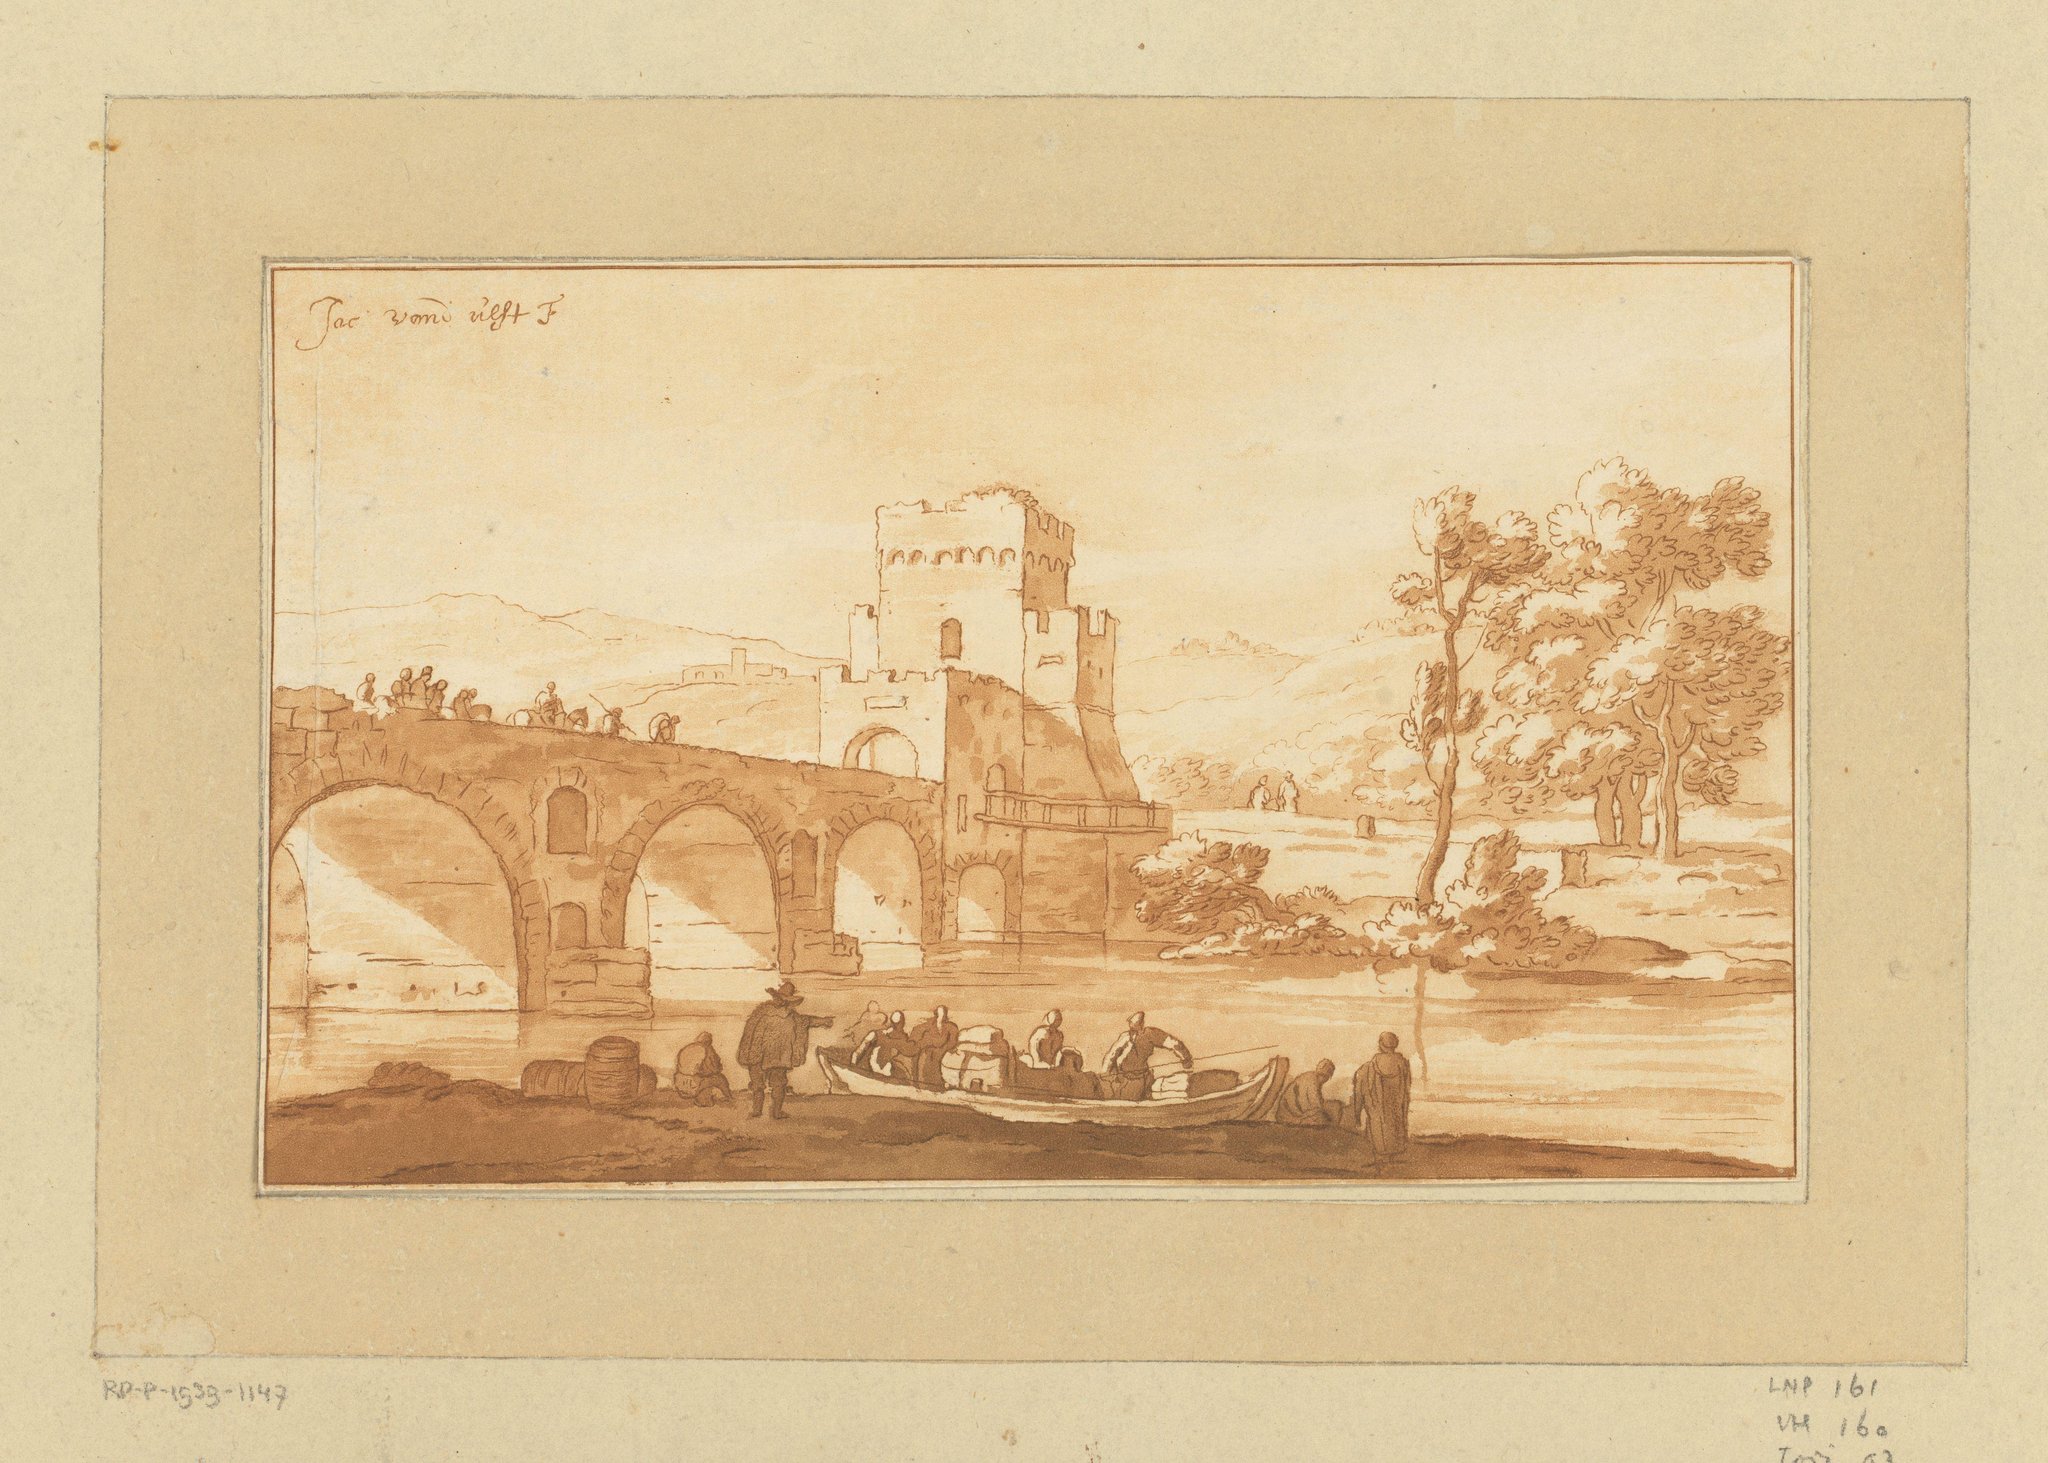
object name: print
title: Ponte Molle bij Rome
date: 1741-1803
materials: paper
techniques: etching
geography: amsterdam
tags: landscape with bridge, viaduct or aqueduct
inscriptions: collector's mark: ‘RIJKS / MUSM’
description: Cornelis Brouwer heeft in samenwerking met C.S. Roos een aantal prenttekeningen uitgegeven welke op het verso het signatuur C.Brouwer fecit en C.S. Roos excudit Amst. dragen. De prent werd opgenomen in: Collection d'imitations de dessins d'après les principaux maîtres hollandais et flamands, Londen, C. Josi, 1821.